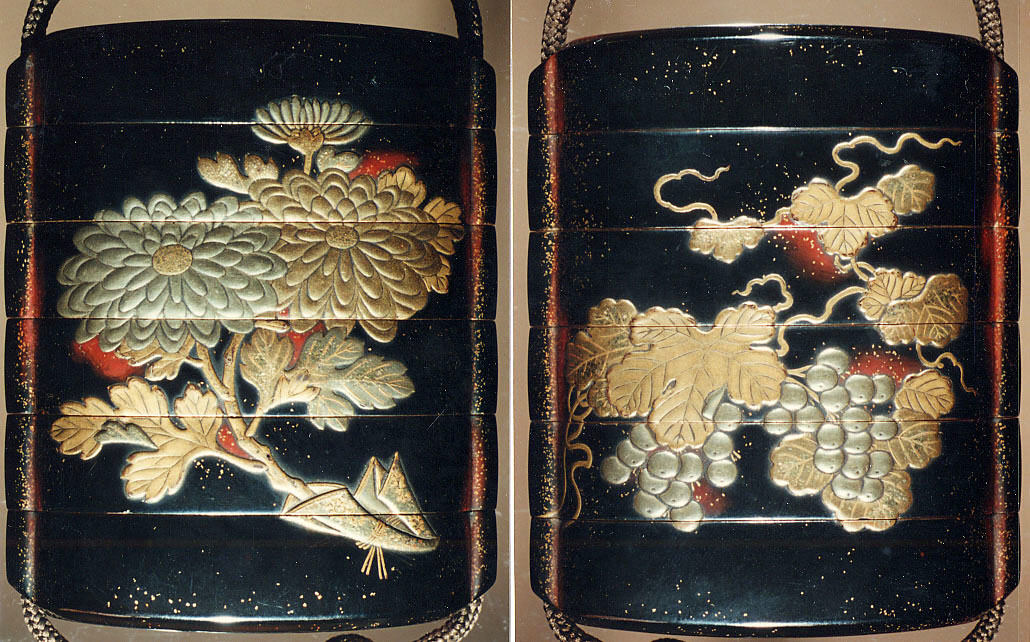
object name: inrō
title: Case (Inrō) with Design of Leafy Grapevines (obverse); Chrysanthemum Spray (reverse)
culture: japanese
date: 1701-1900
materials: gold, ivory, lacquer, silver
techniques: carving, maki-e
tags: grapes,flowers